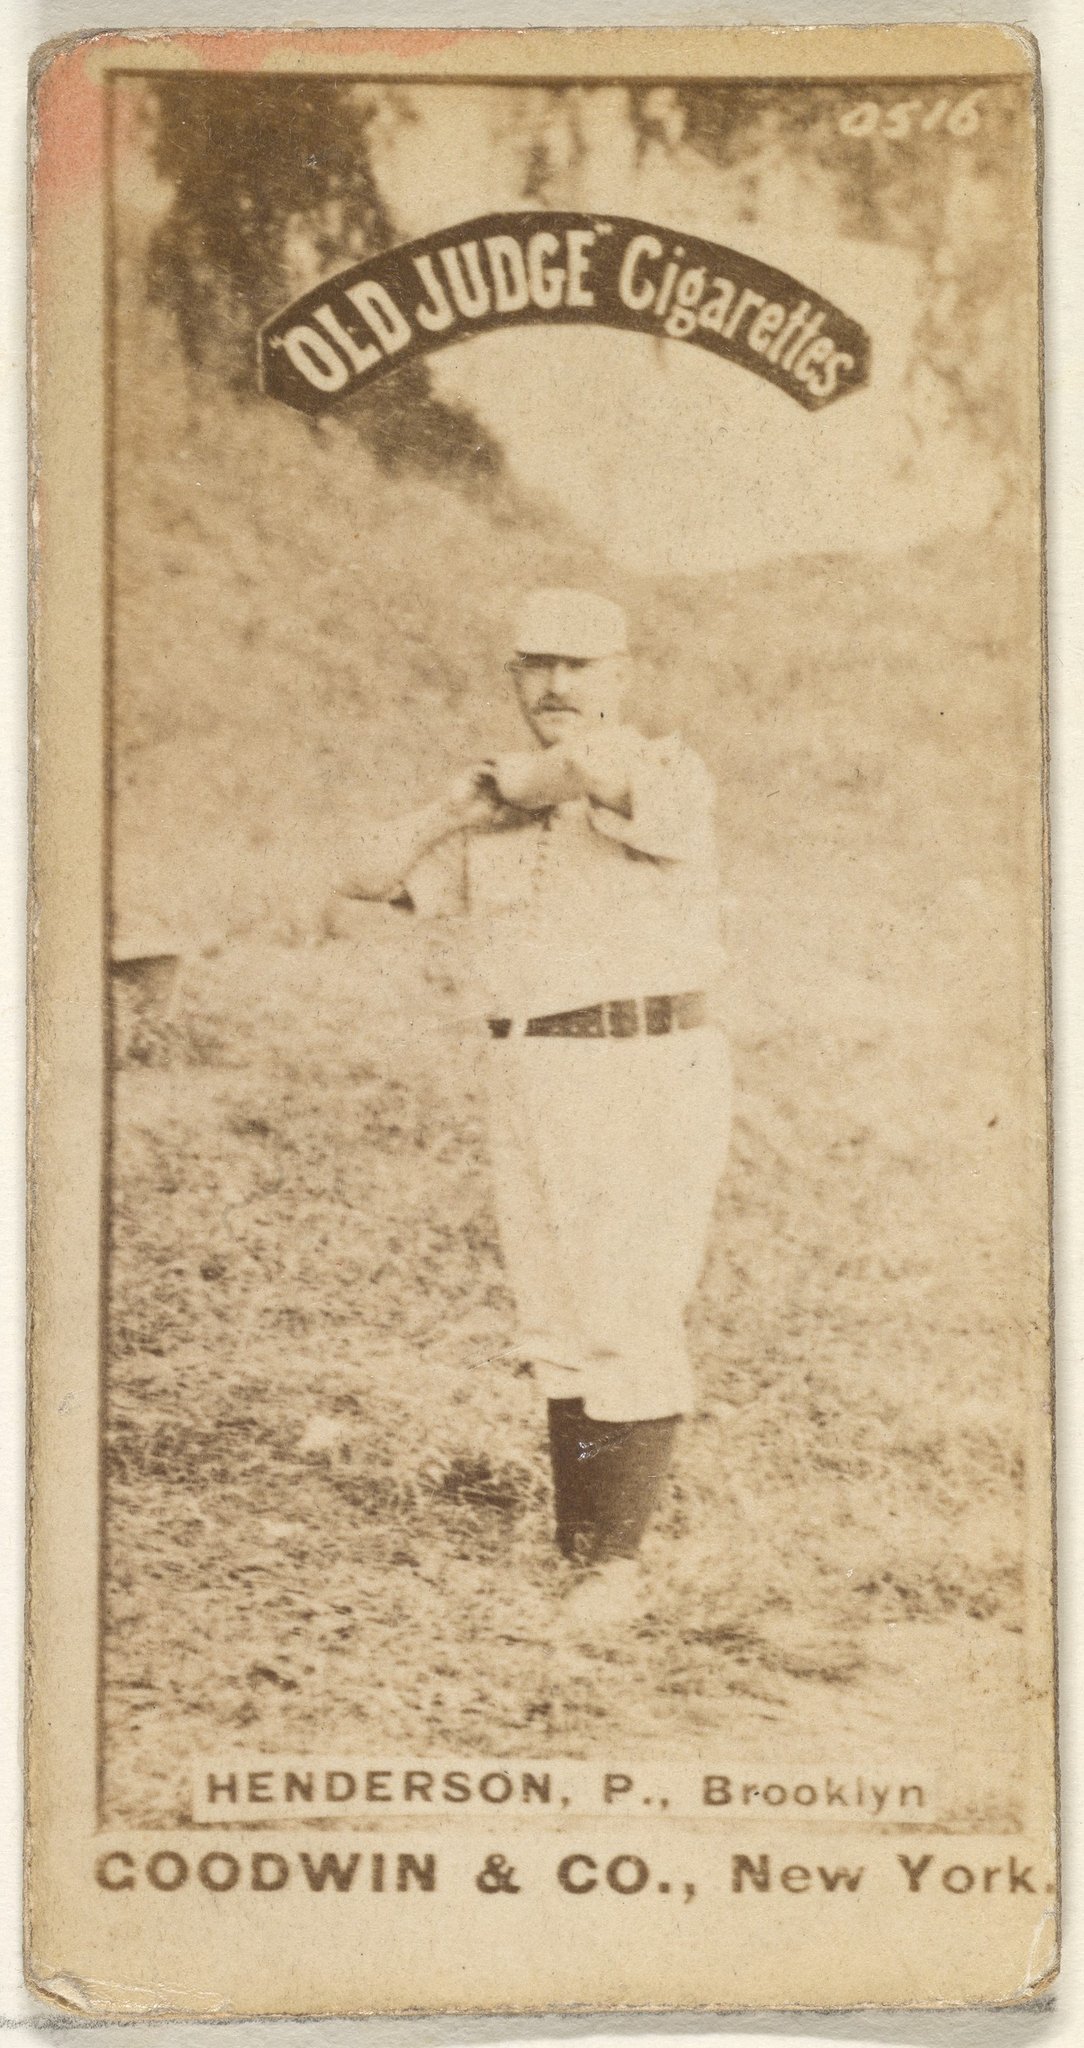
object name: baseball card, photograph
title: Henderson, Pitcher, Brooklyn, from the Old Judge series (N172) for Old Judge Cigarettes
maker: goodwin & company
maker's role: publisher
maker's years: 1850-1950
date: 1887-1890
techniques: albumen silver print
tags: men,portraits,baseball,athletes